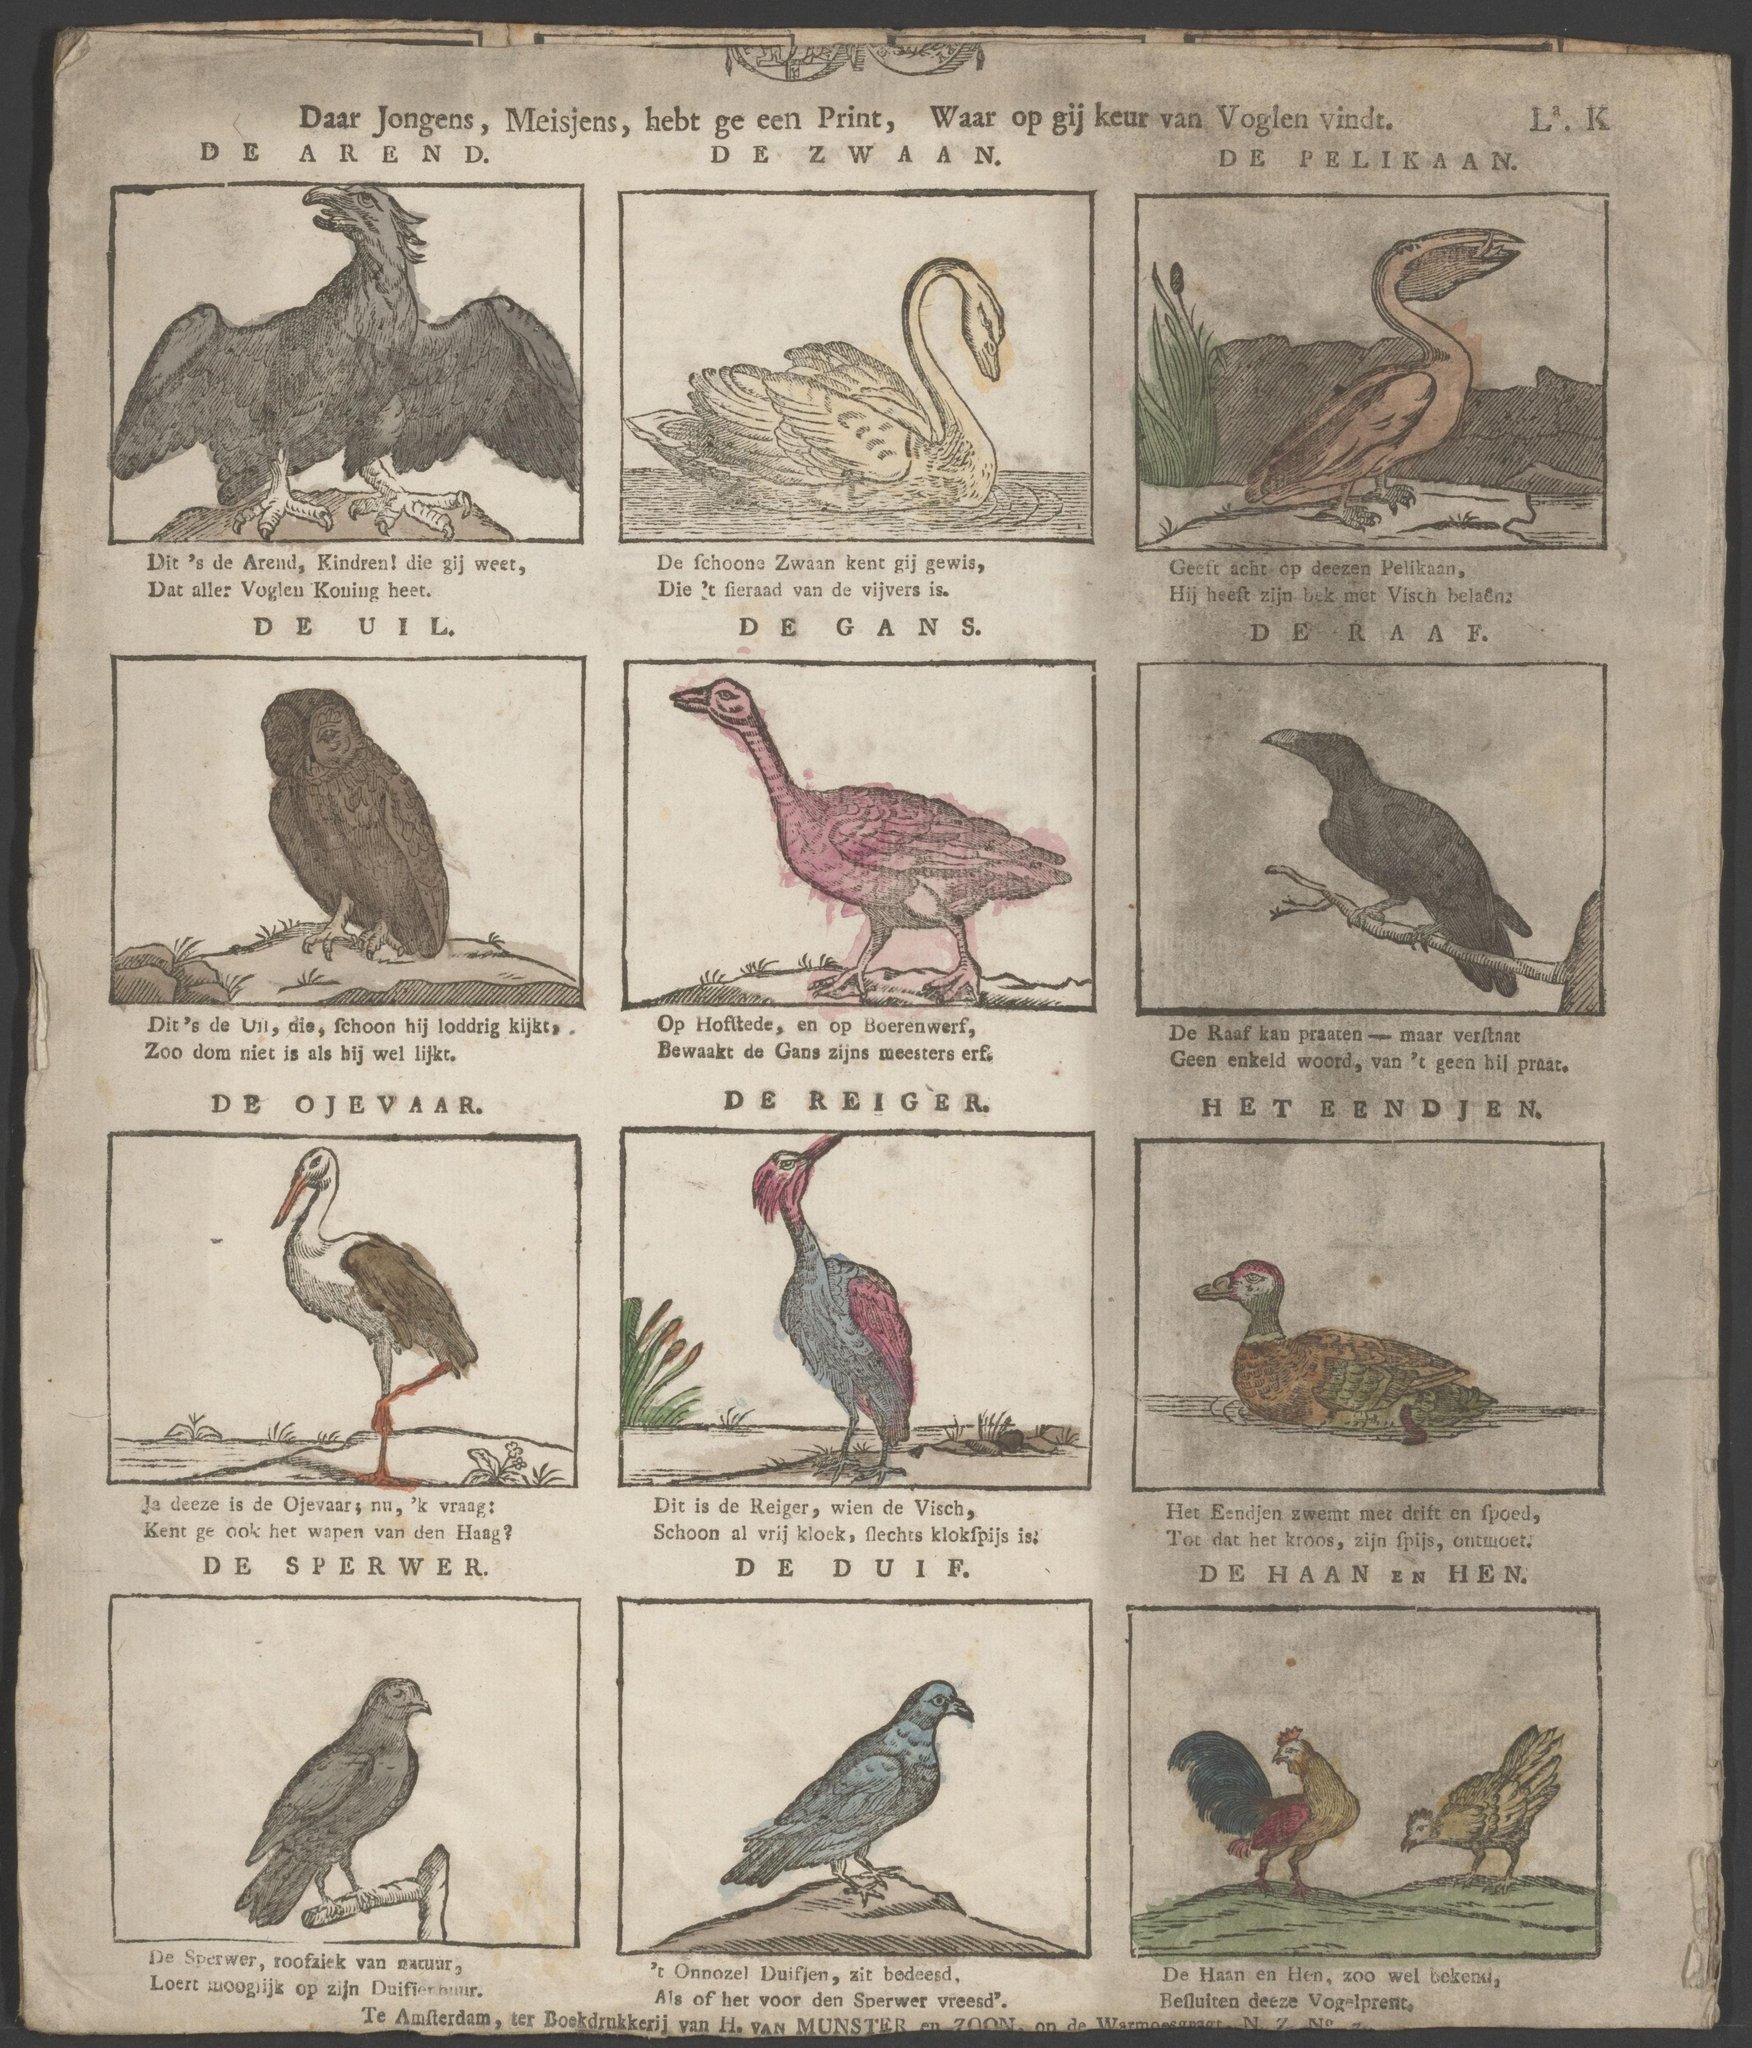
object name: popular print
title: Daar jongens, meisjens, hebt ge een print, Waar op gij keur van voglen vindt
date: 1784-1849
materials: paper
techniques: hand coloring, letterpress printing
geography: amsterdam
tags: birds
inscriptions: collector's mark: Lugt 1641, stamp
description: Blad met twaalf voorstellingen van vogels. Boven elke afbeelding de naam van het dier, onder elke afbeelding een tweeregelig vers. Genummerd rechtsboven: La.K. Onderwerpsrubrieken binnen de Atlas Zeden en Gewoonten: Zeden en gewoonten in engeren zin, Des menschen begin, midden en einde, Kinderprenten opgeplakt op karton.